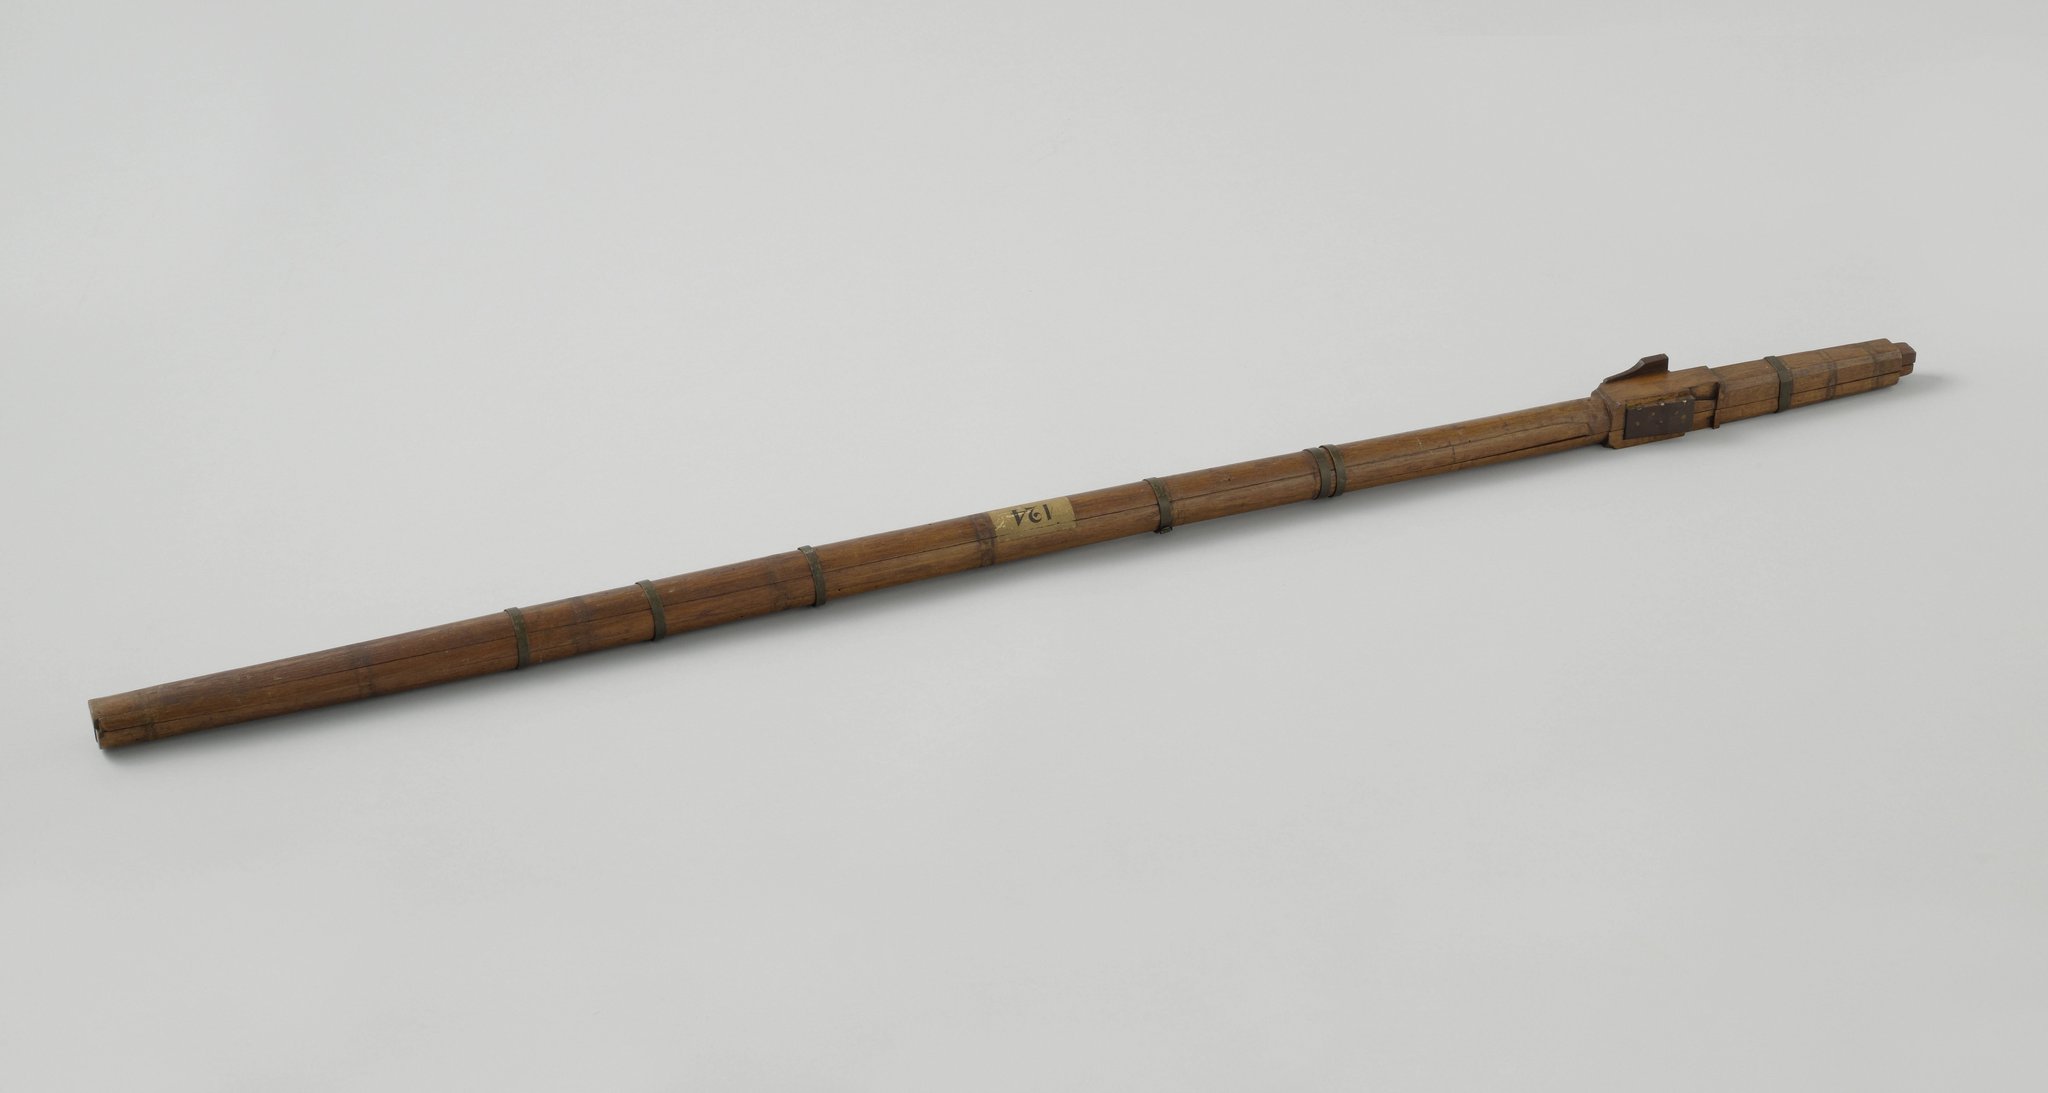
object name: demonstration model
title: Model of a Made Mast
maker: Anonymous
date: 1780-1840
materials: brass, wood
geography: netherlands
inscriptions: label: ‘124’ former inventory label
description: Ronde mast met vierkante top, hommer met oren en rijbed. De mast zelf bestaat uit vijf delen: drie zware delen zijn tegen elkaar gezet met kluften aan de binnenkant, één aan de voorkant en twee aan de achterkant; twee dunne wangen ronden het geheel af. De delen worden door kuipbanden bijeengehouden. Het rijbed is een verdikking van het voorste deel. Dit model kan uiteengenomen worden.